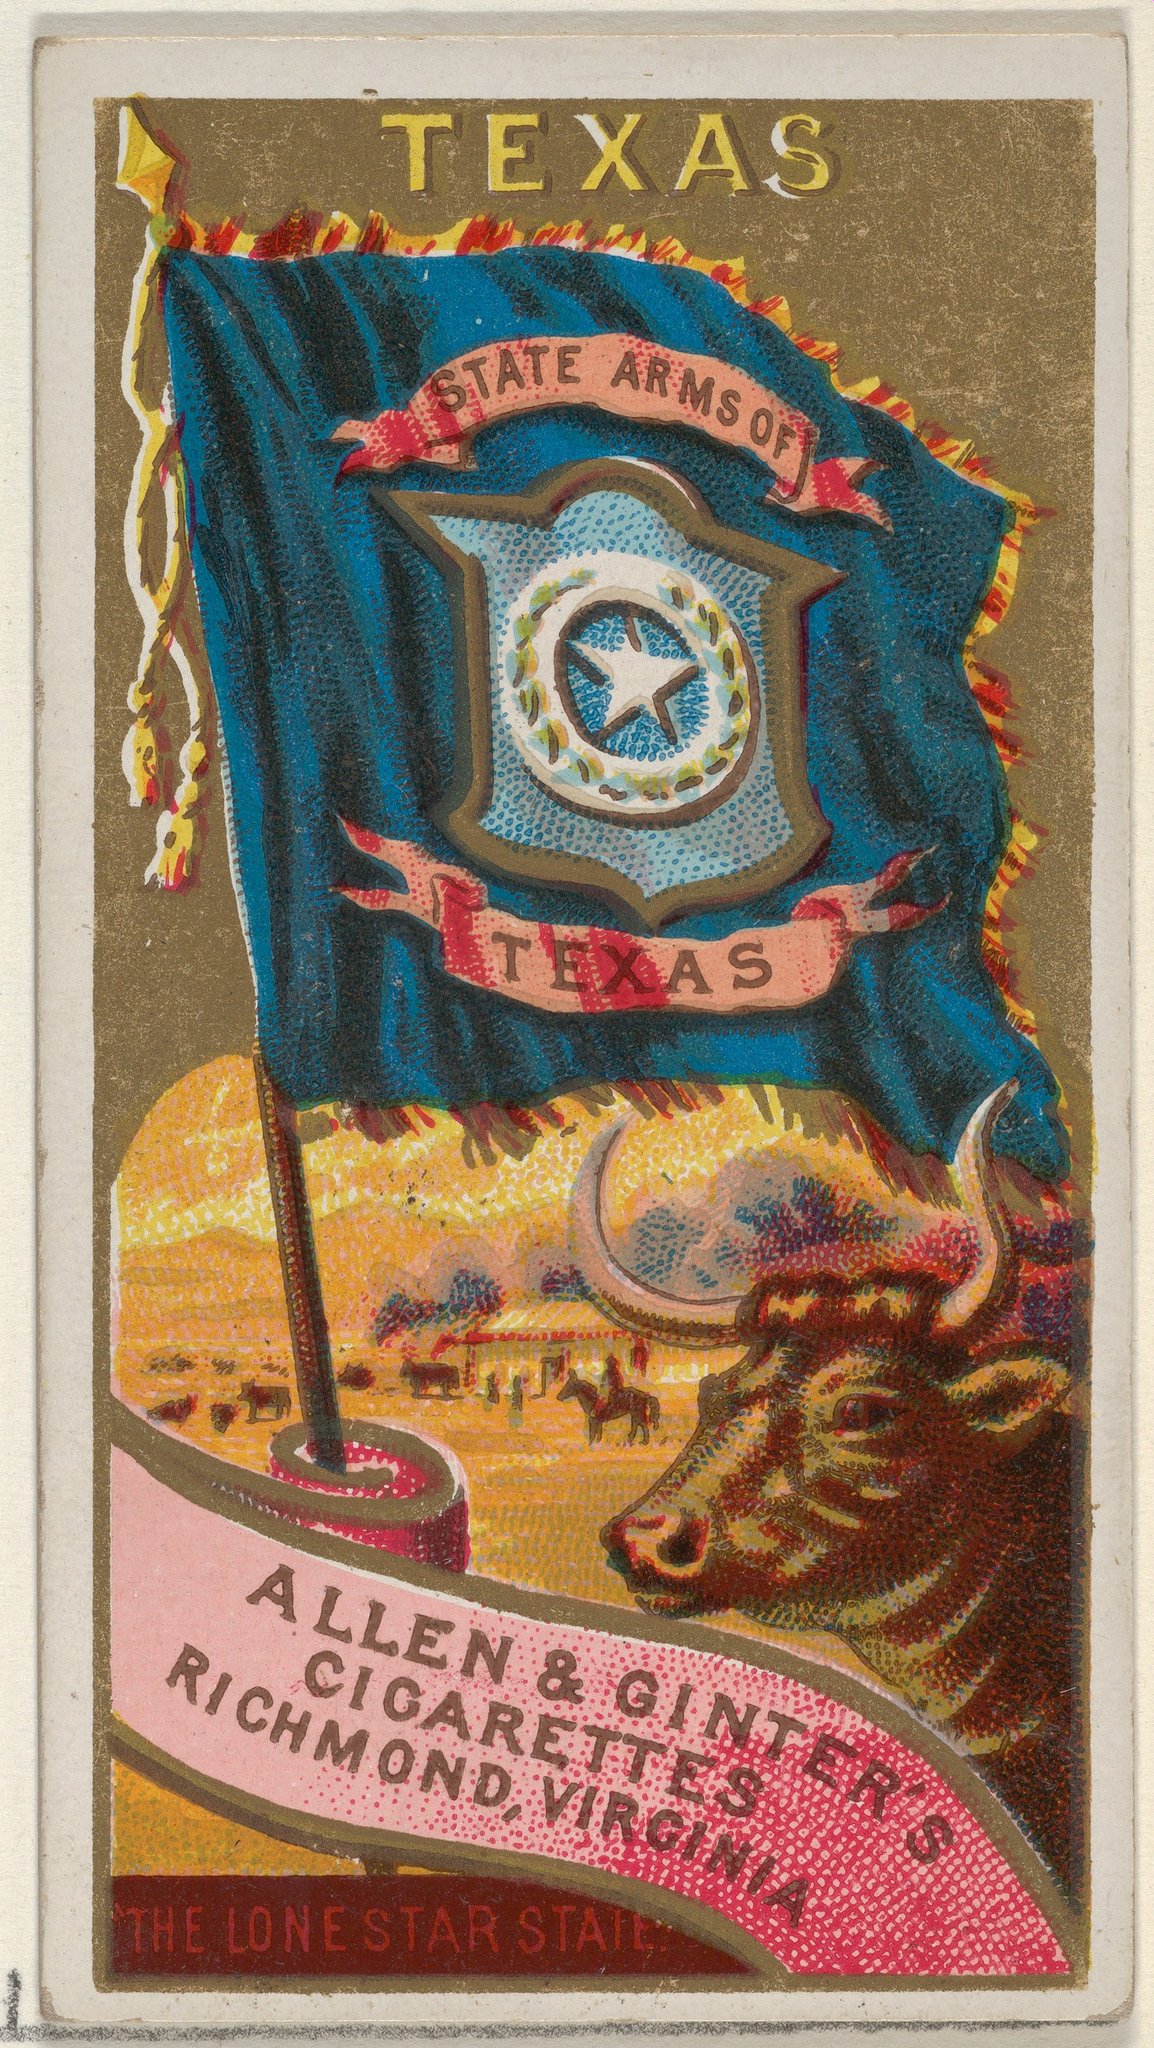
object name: print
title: Texas, from Flags of the States and Territories (N11) for Allen & Ginter Cigarettes Brands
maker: allen & ginter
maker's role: publisher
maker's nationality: american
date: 1888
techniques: color lithograph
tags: flags